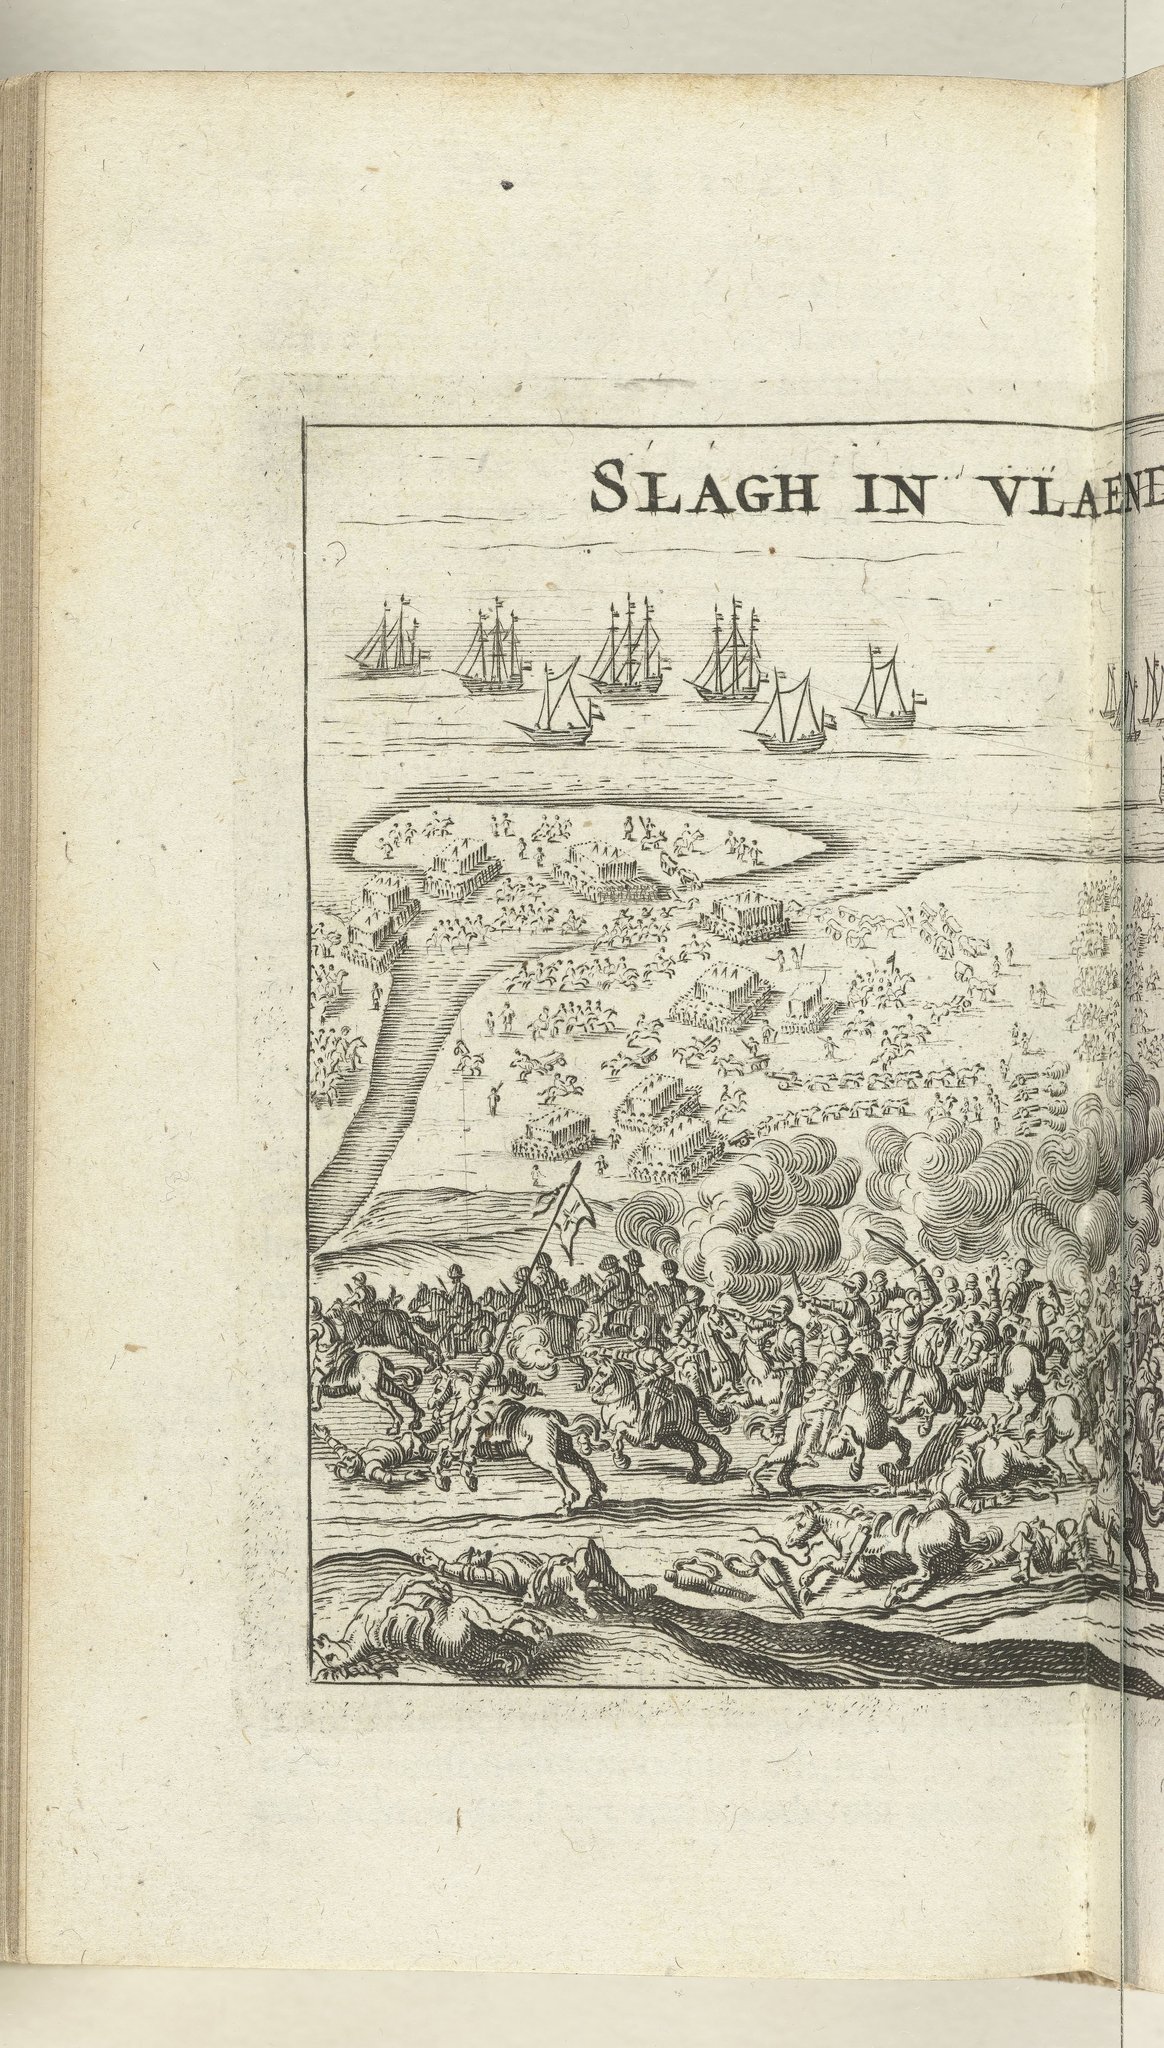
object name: print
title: Slagh in Vlaenderen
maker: Anonymous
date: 1662-1664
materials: paper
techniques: etching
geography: northern netherlands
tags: maurice (prince of orange), battle, battle of nieuwpoort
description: Illustratie in: A. Montanus, 'T leven en bedryf der prinsen van Oranje, Wilhelm de eerste, Maurits, Frederik Henrik, Wilhem de tweede, Wilhem de derde : aengehecht met de daden der Nassouwsche stam, van het jaar 682 tot dese tyd, 5 delen in 2 banden, A. Montanus, Amsterdam 1664. Band I: deel Maurits, p. 220-221. In het exemplaar in de collectie van de Rijksmuseum Research Library (330 F 12-13).